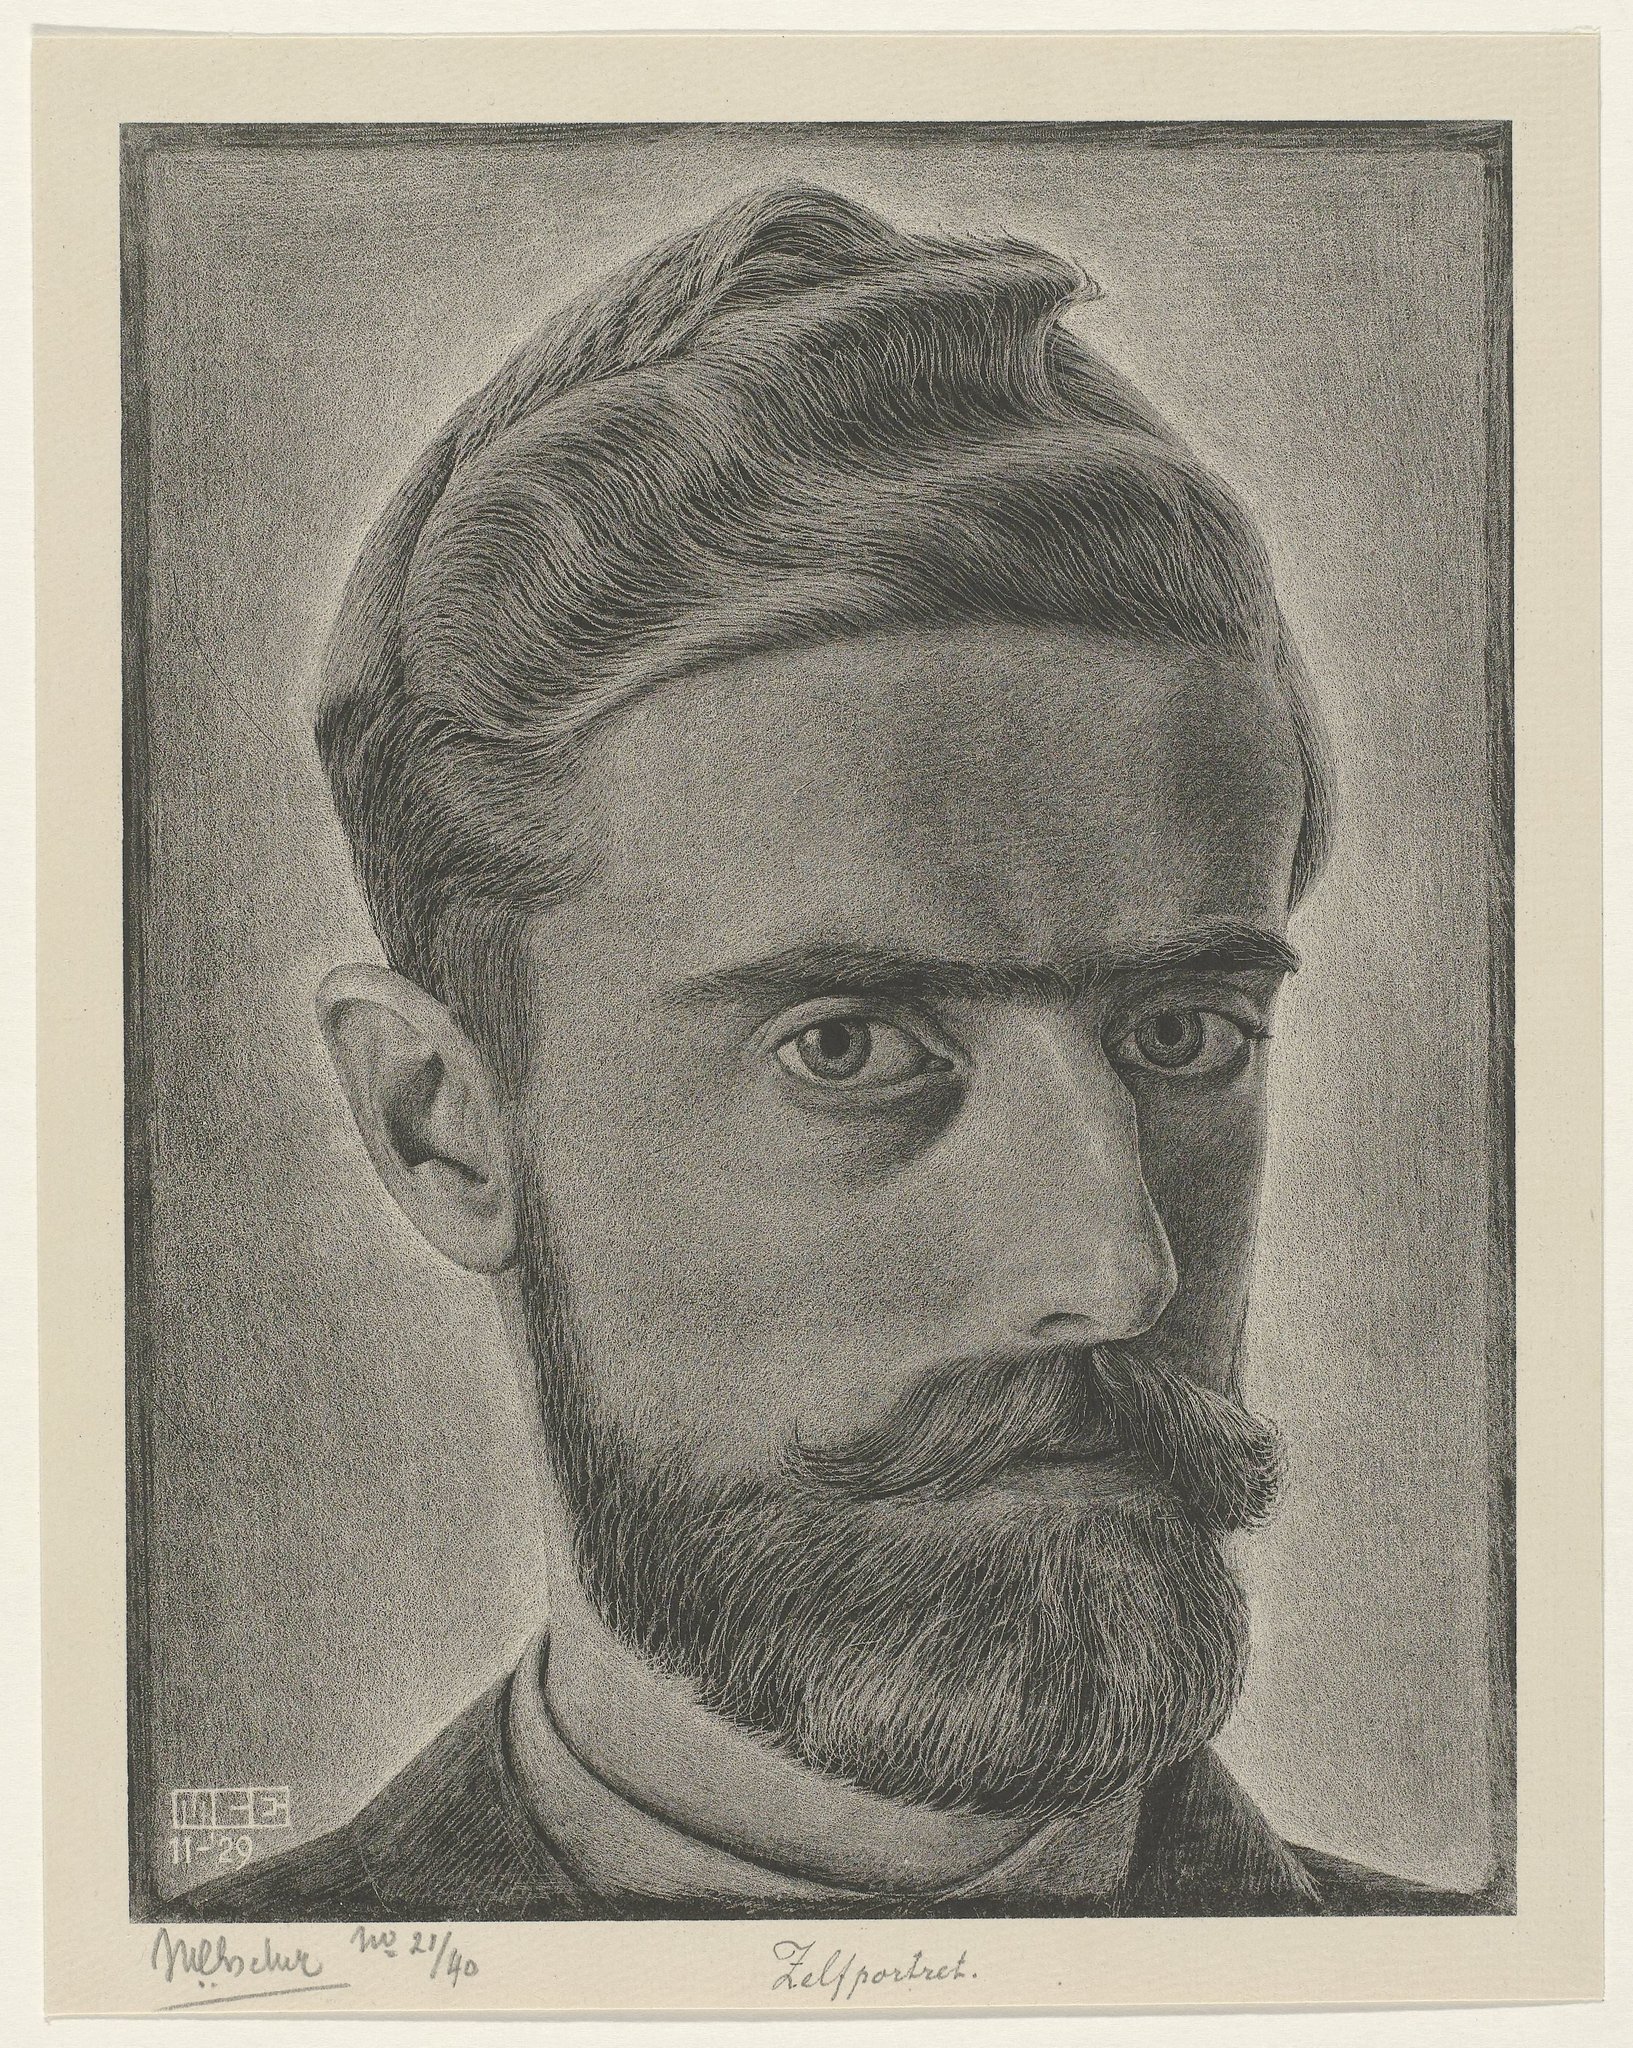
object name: opticaprent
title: Gezicht op een plein te Sint-Petersburg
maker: Anonymous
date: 1700-1799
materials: paper, watercolor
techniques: brush, etching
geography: bassano del grappa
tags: column (marking grave), square, place, circus, etc. (+ city(-scape) with figures, staffage)